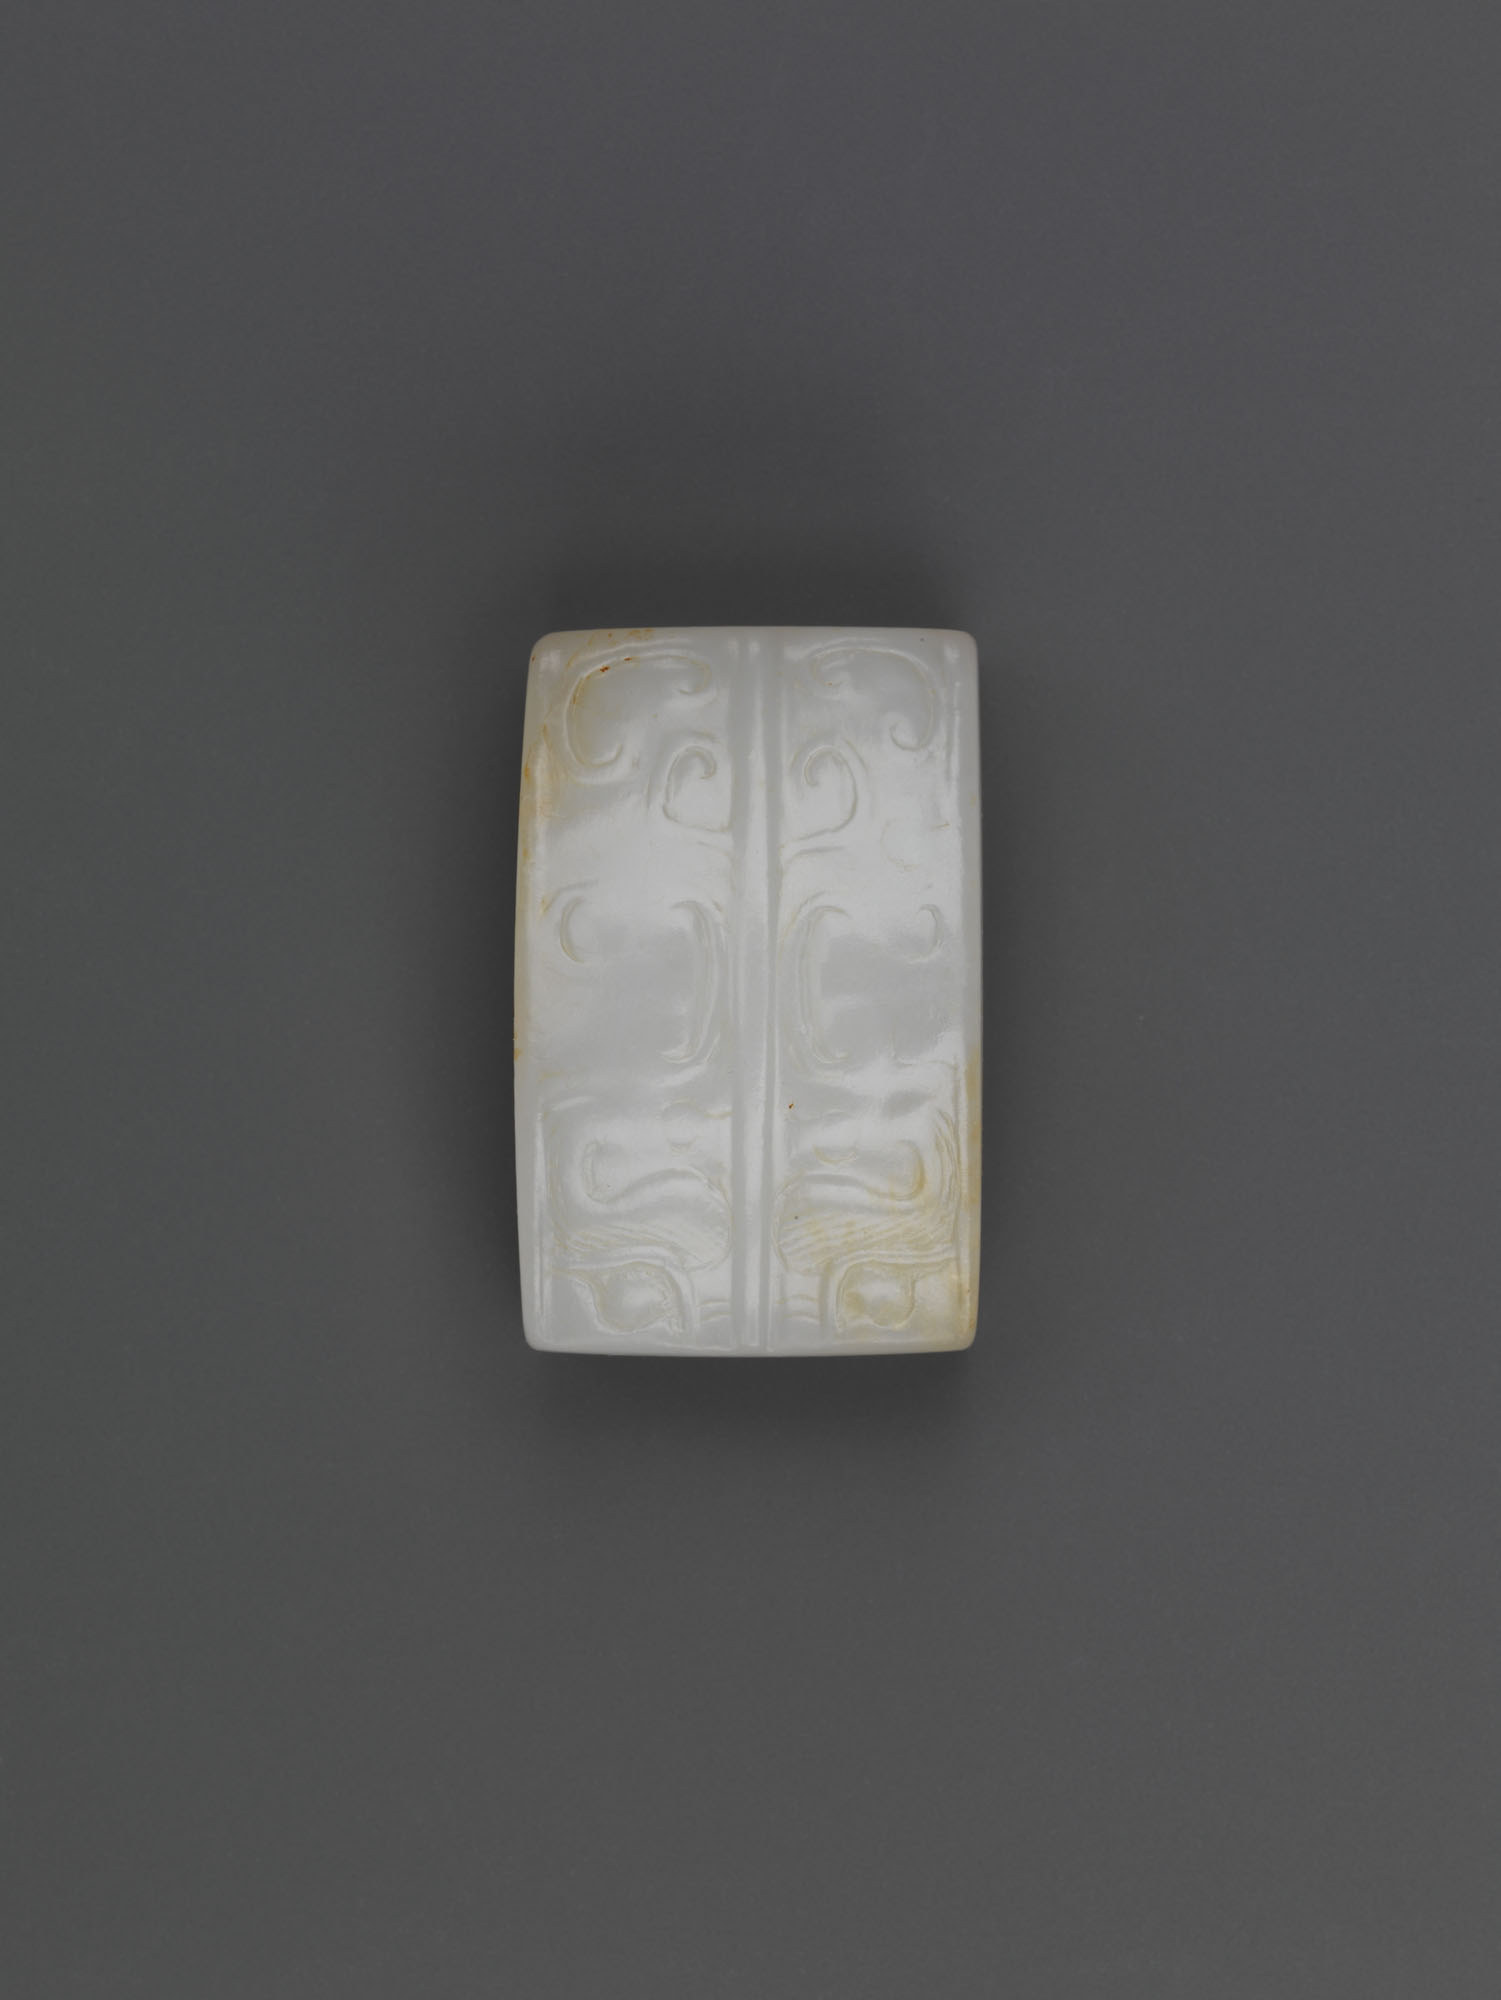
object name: scabbard slide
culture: chinese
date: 300-201 BCE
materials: jade